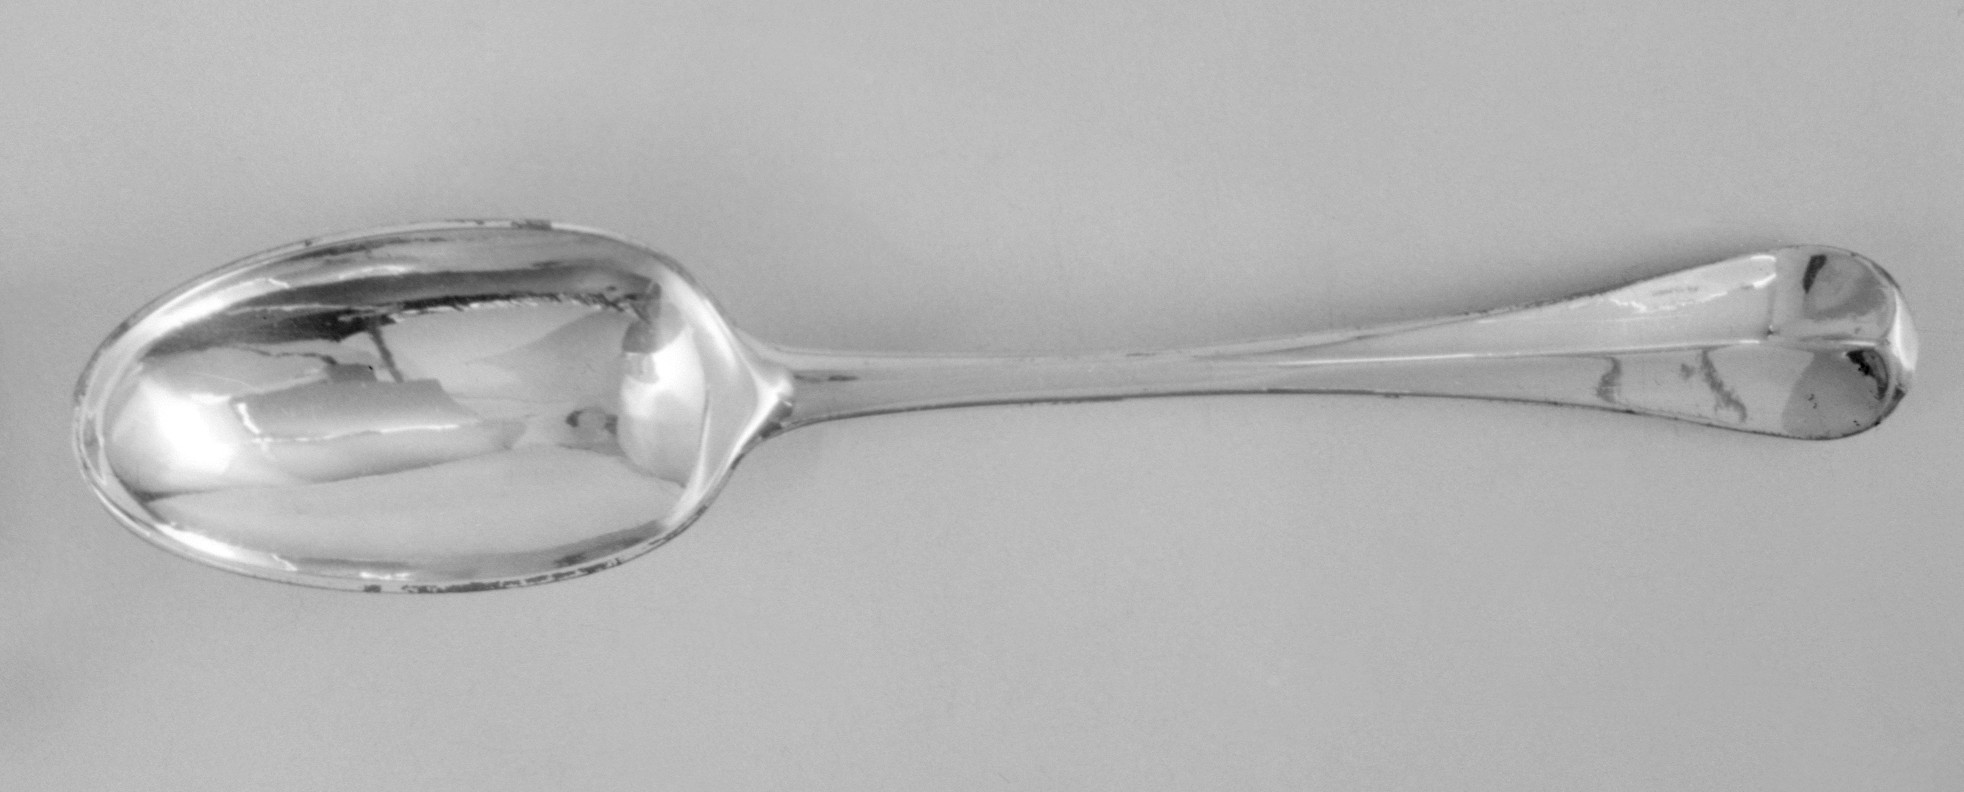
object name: spoon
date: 1717-1718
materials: silver